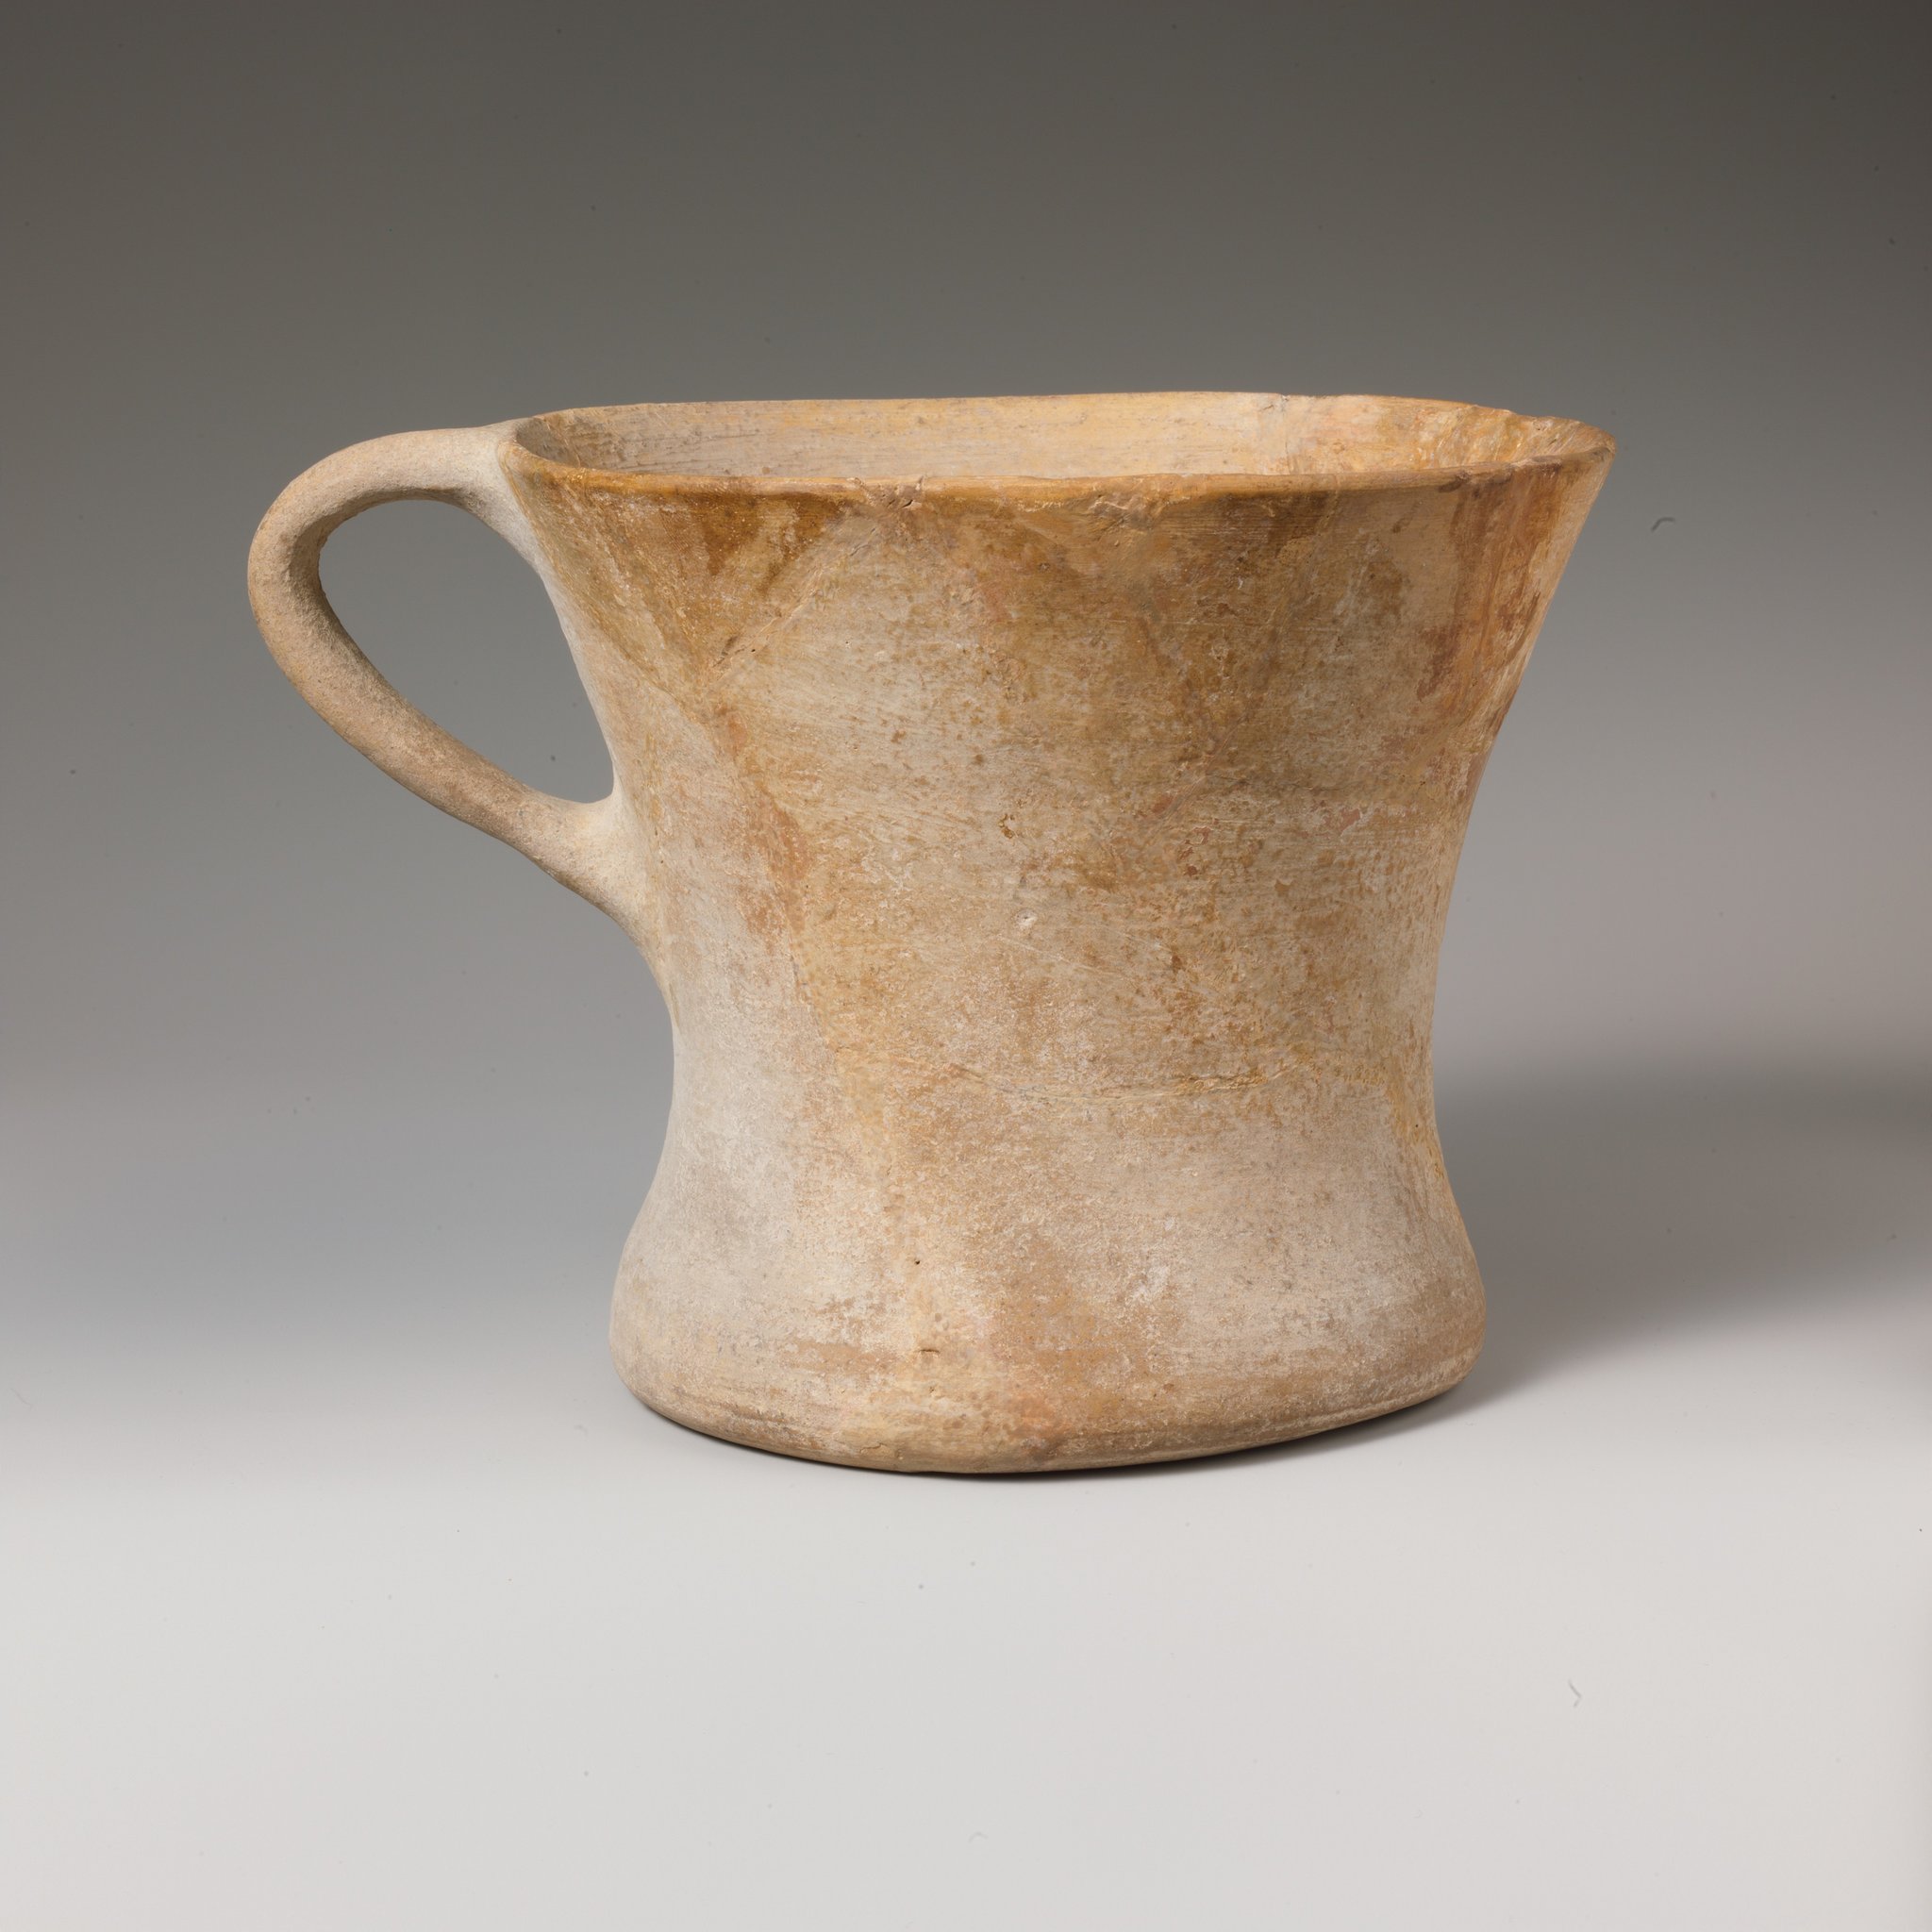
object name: cup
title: Terracotta tankard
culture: minoan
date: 1400-1200 BCE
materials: terracotta